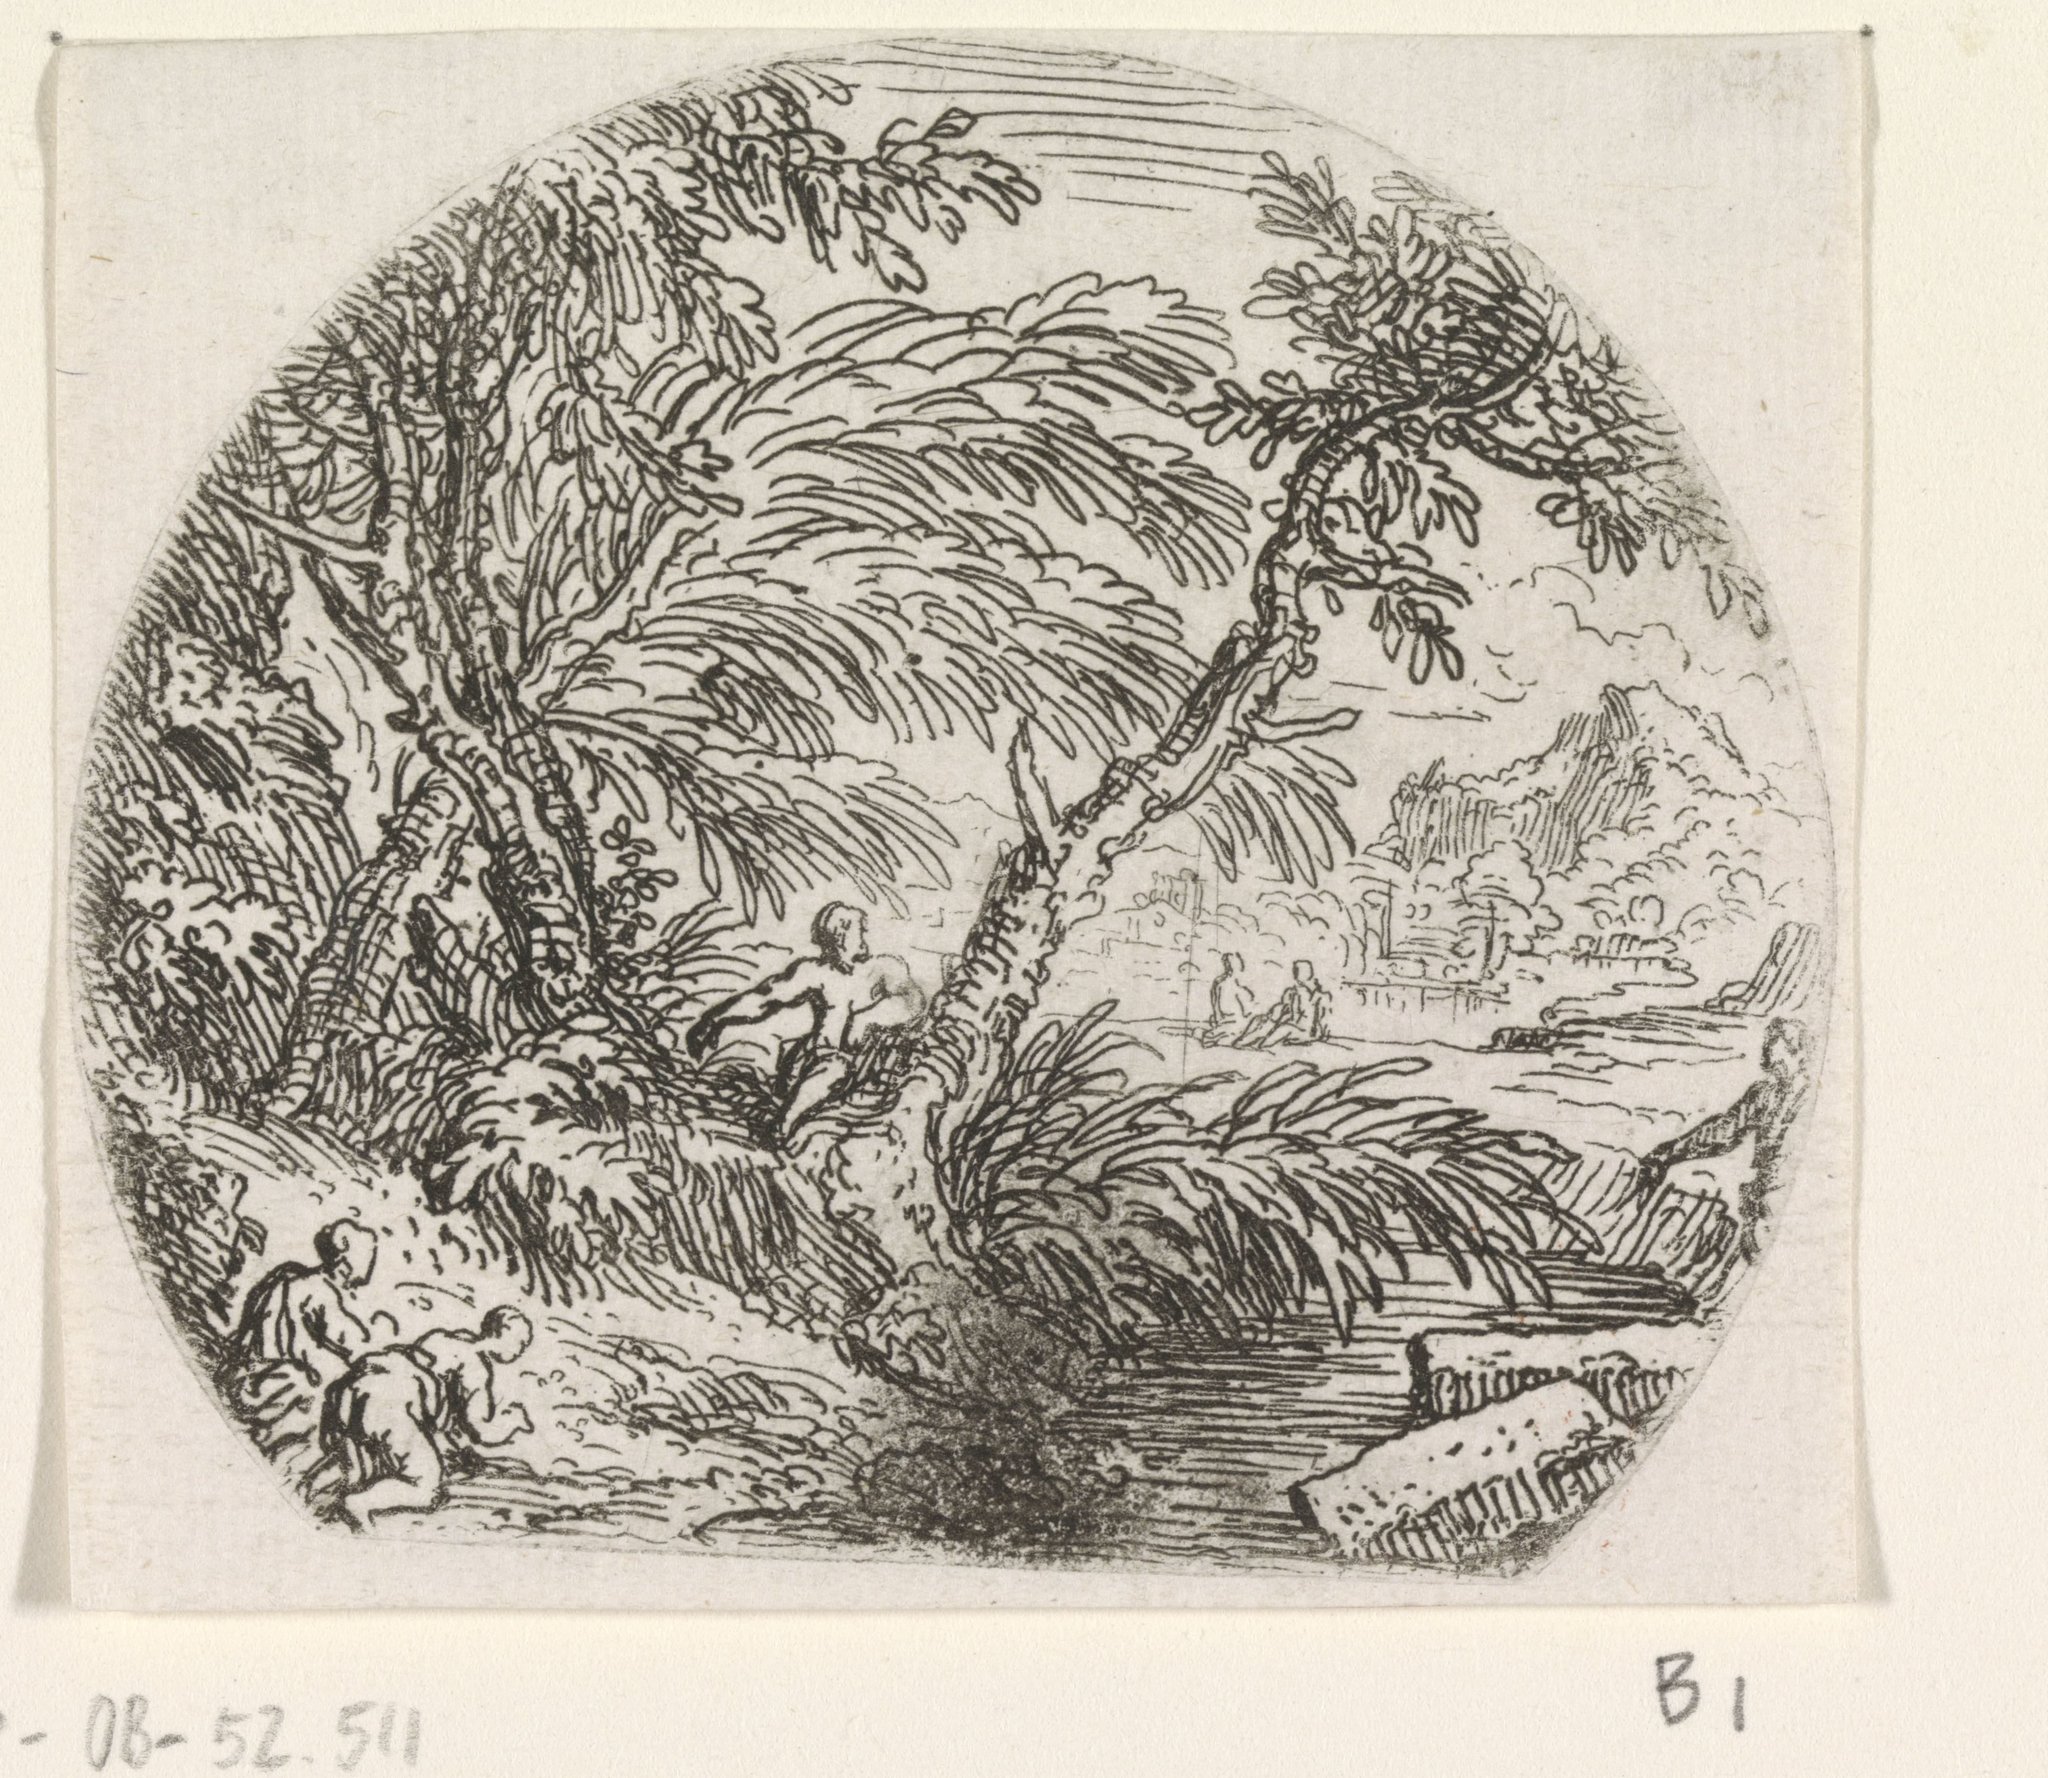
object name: print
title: Landschap met twee knielende figuren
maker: abraham genoels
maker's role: draughtsman, print maker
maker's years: 1640-1723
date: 1650-1723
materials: paper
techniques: etching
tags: river (+ landscape with figures, staffage)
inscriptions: collector's mark: Lugt 240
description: Een landschap met twee figuren naast een rivier die knielen voor een andere figuur.